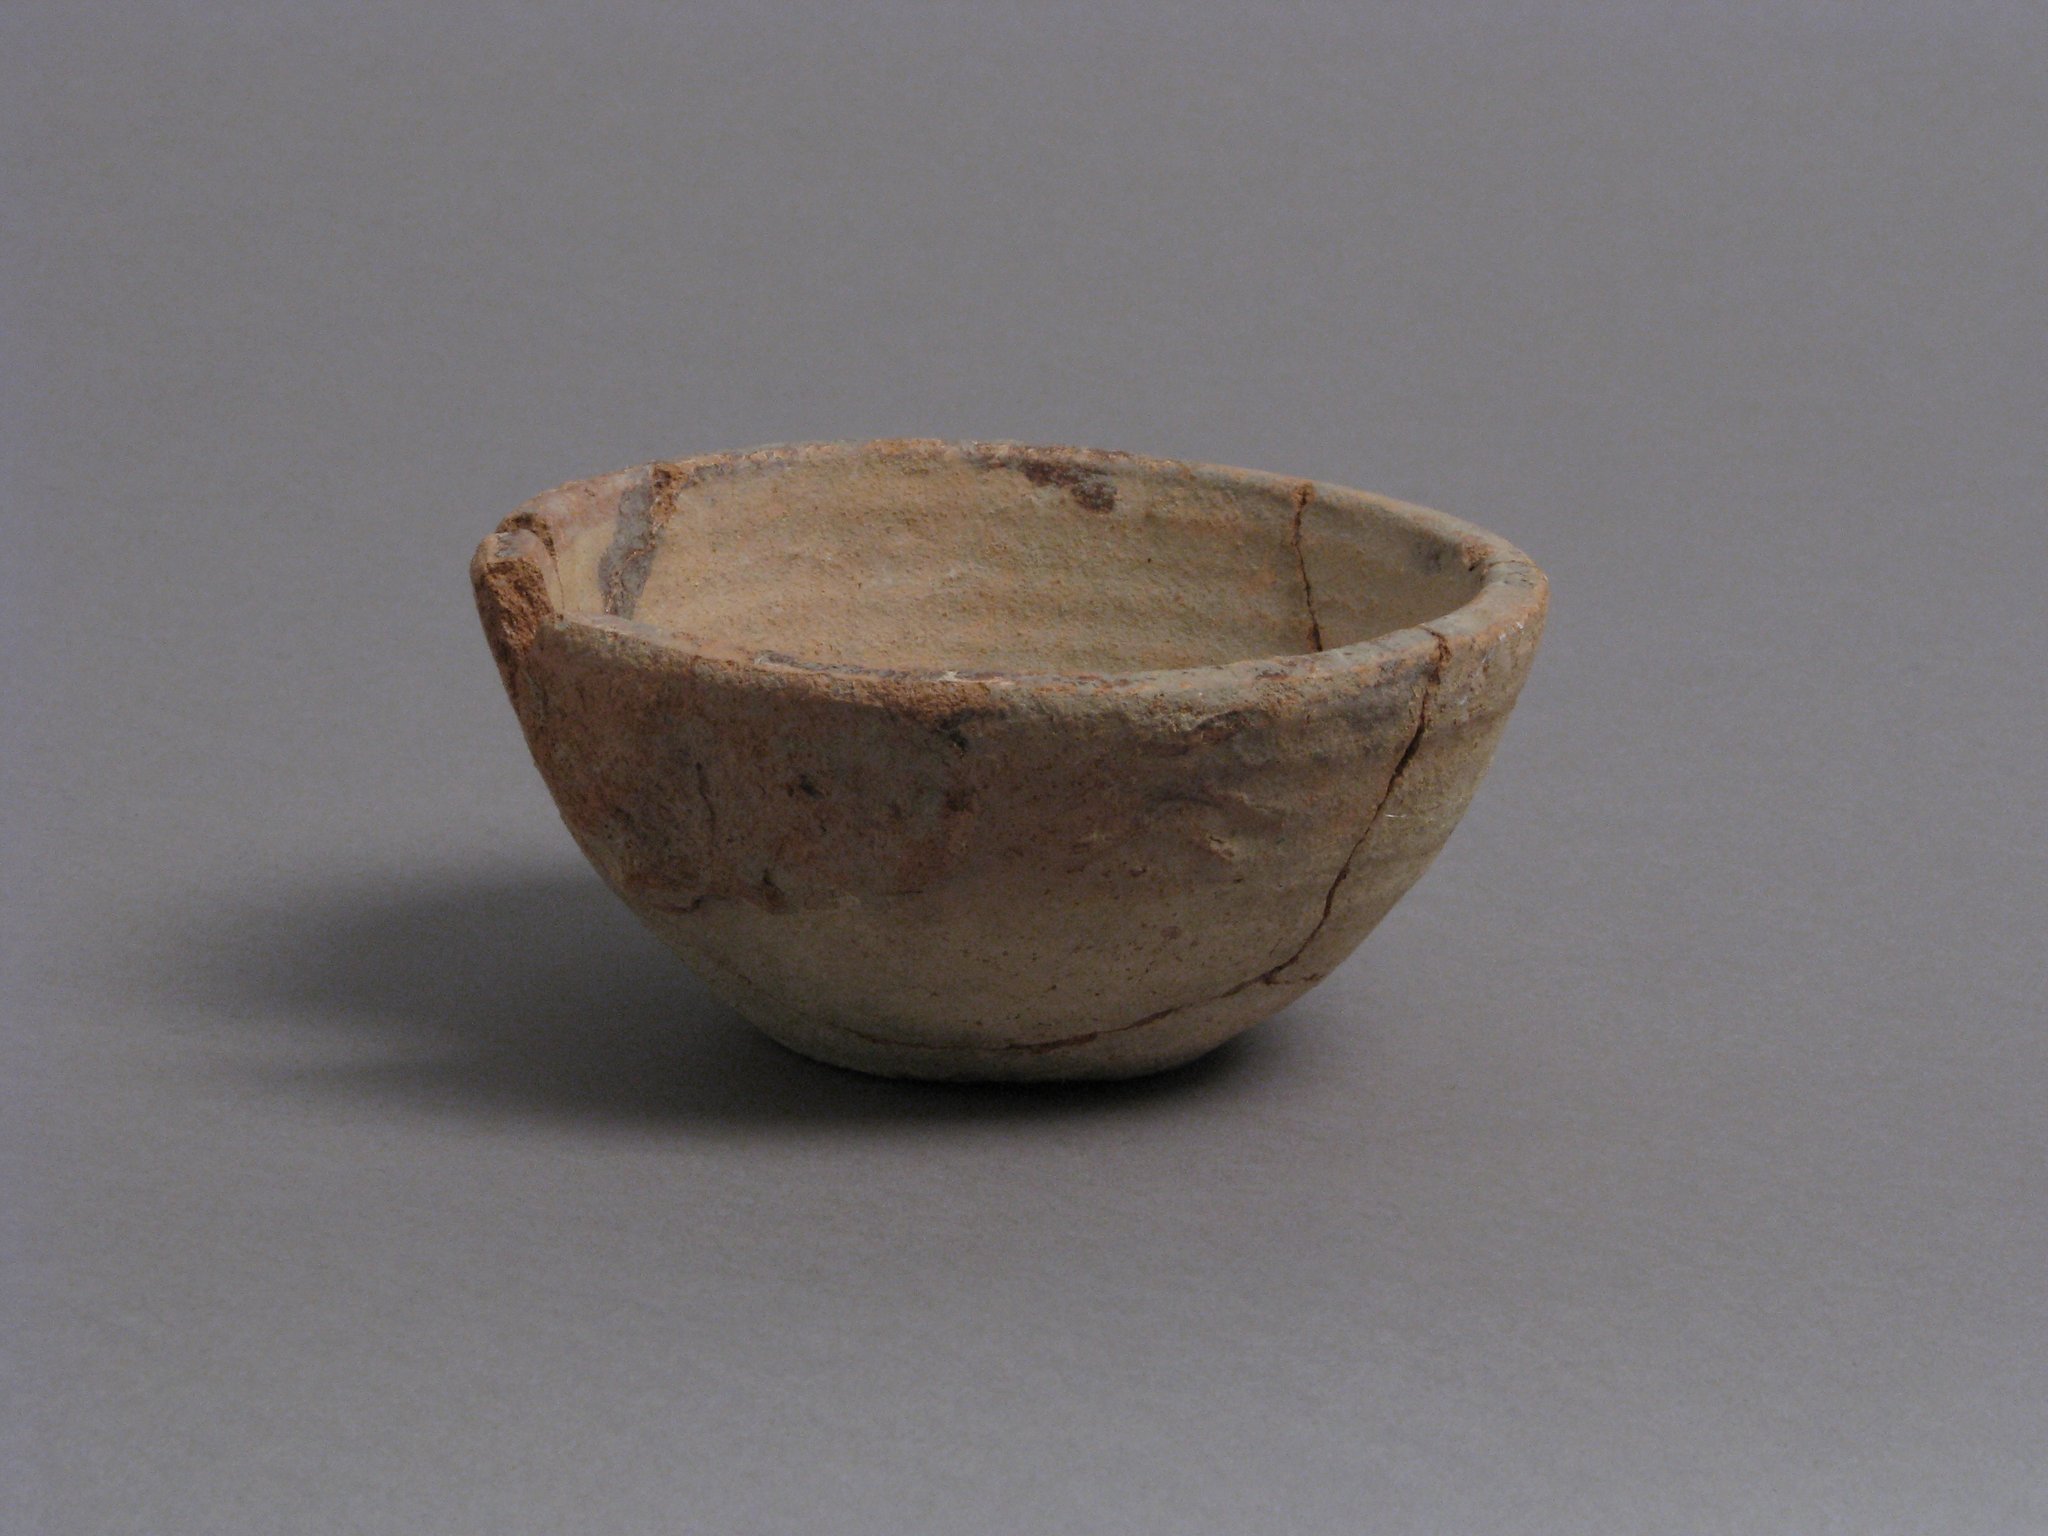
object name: bowl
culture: coptic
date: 301-700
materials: earthenware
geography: egypt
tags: bowls